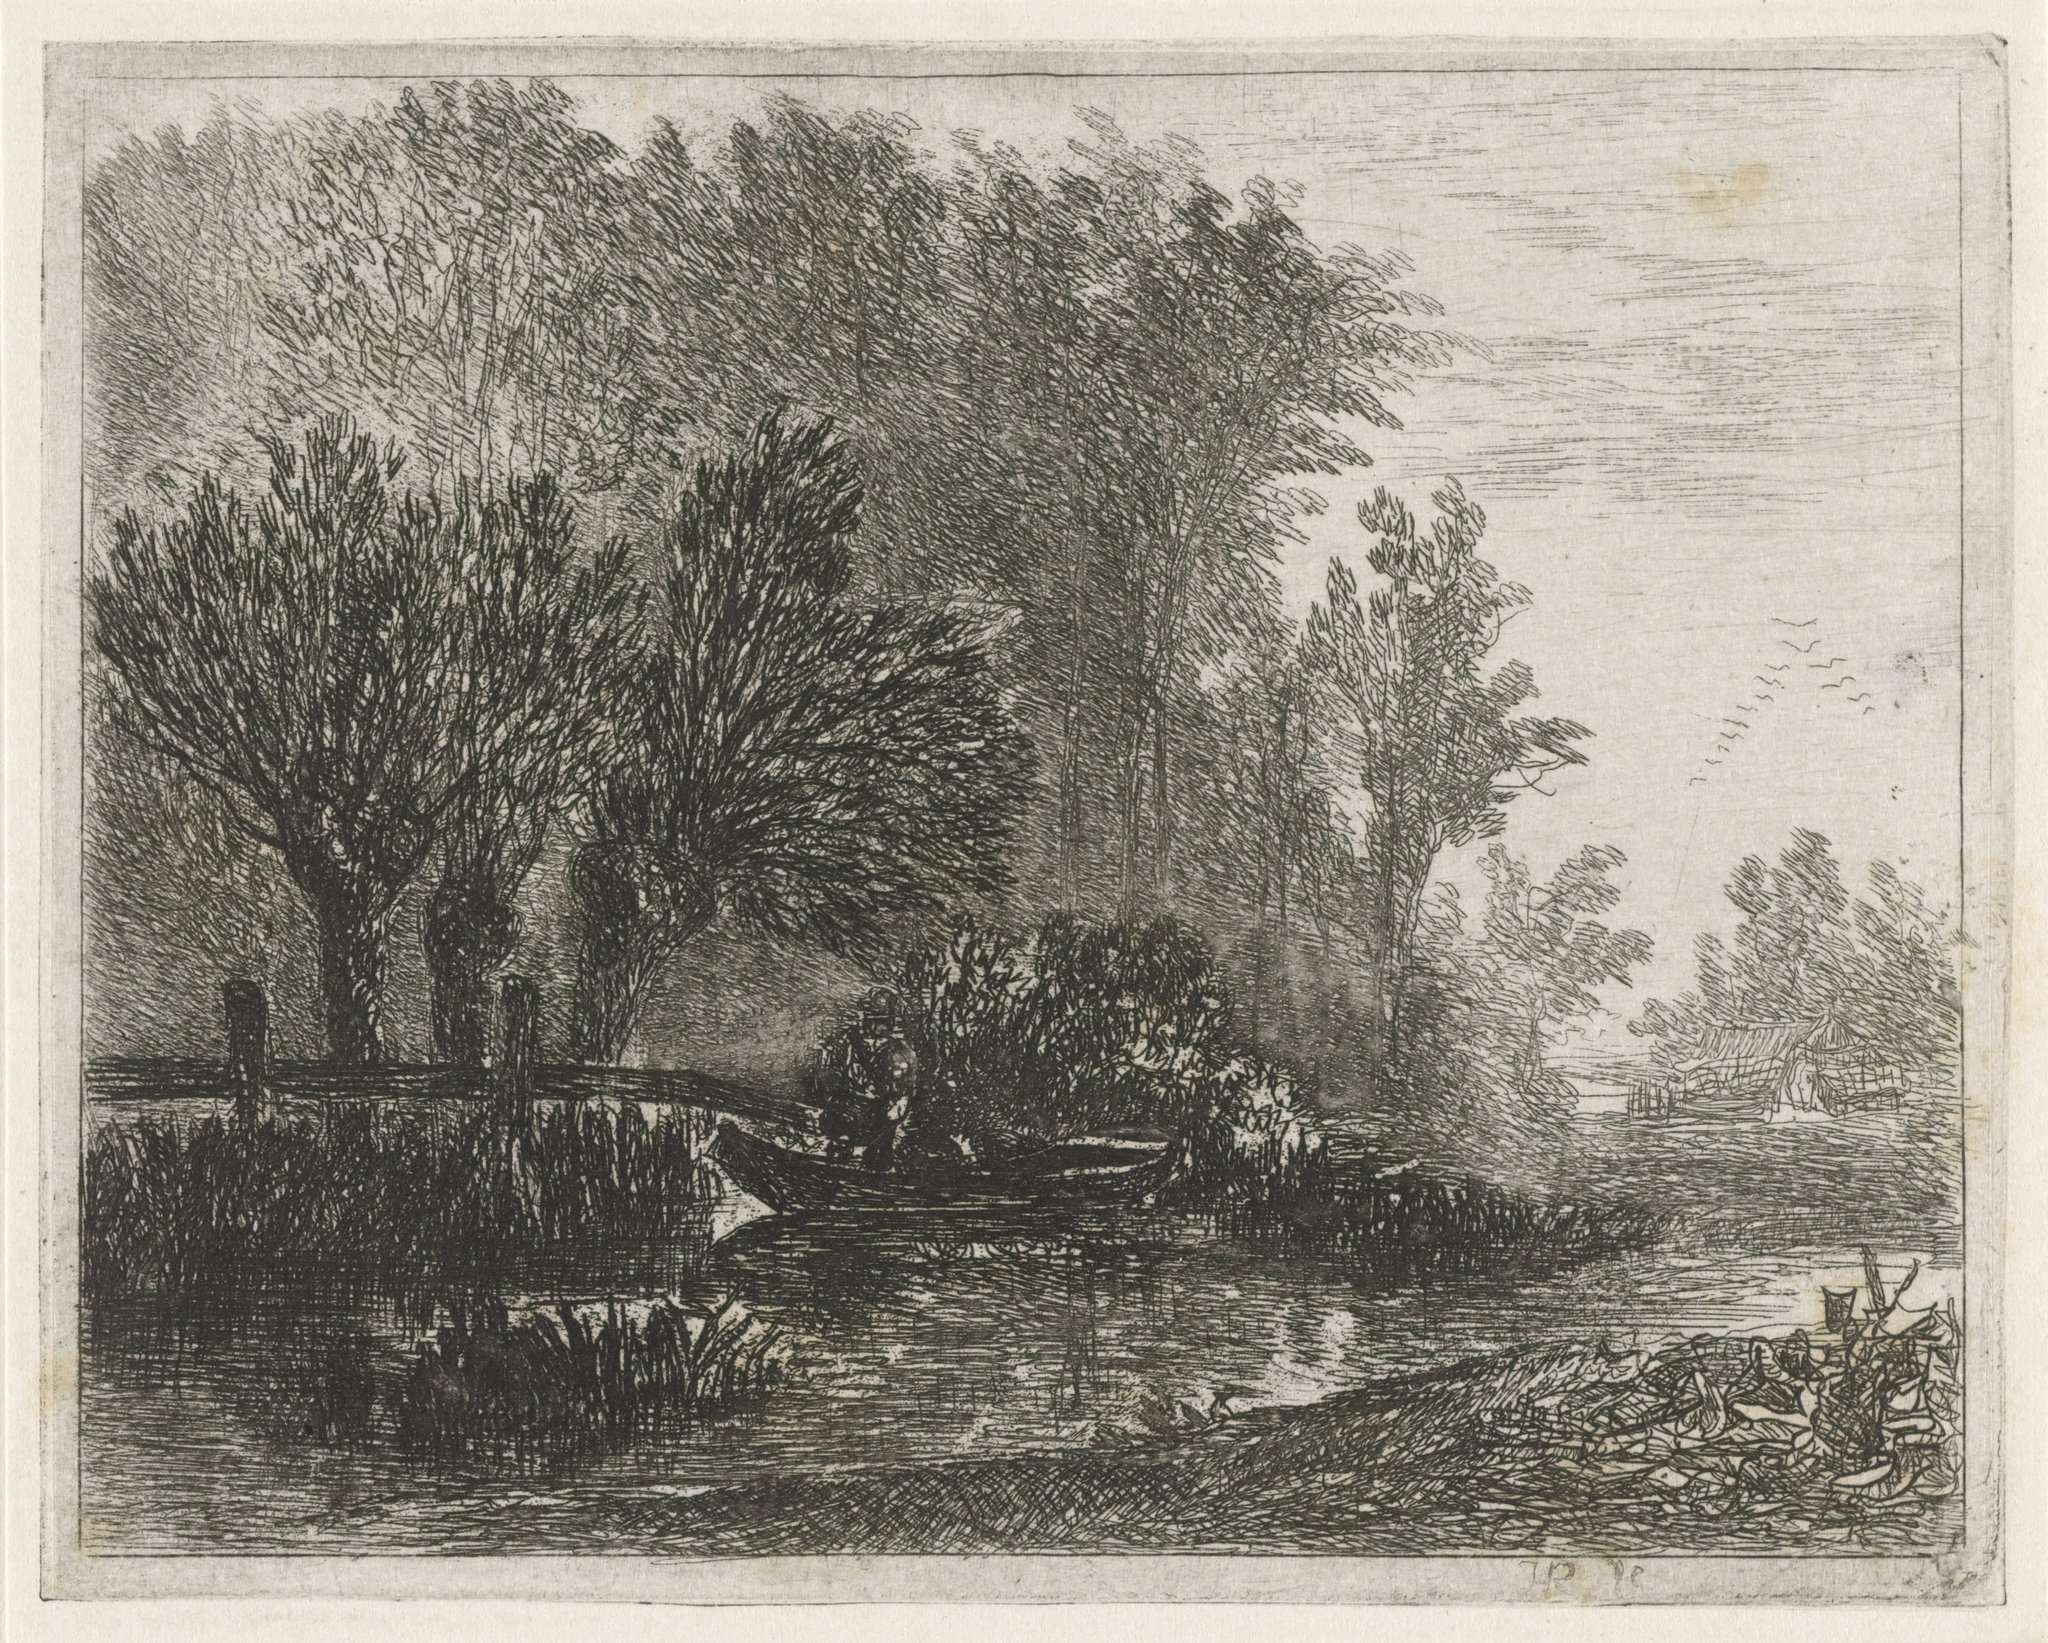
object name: print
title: Visser in een boot aan de bosrand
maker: hermanus jan hendrik van rijkelijkhuysen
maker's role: painter, print maker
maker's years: 1813-1883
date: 1823-1883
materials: paper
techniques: drypoint, etching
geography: utrecht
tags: river, forest, wood, hut, cabin, lodge, fisherman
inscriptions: collector's mark: Lugt 2228, collector's mark: Lugt 1485